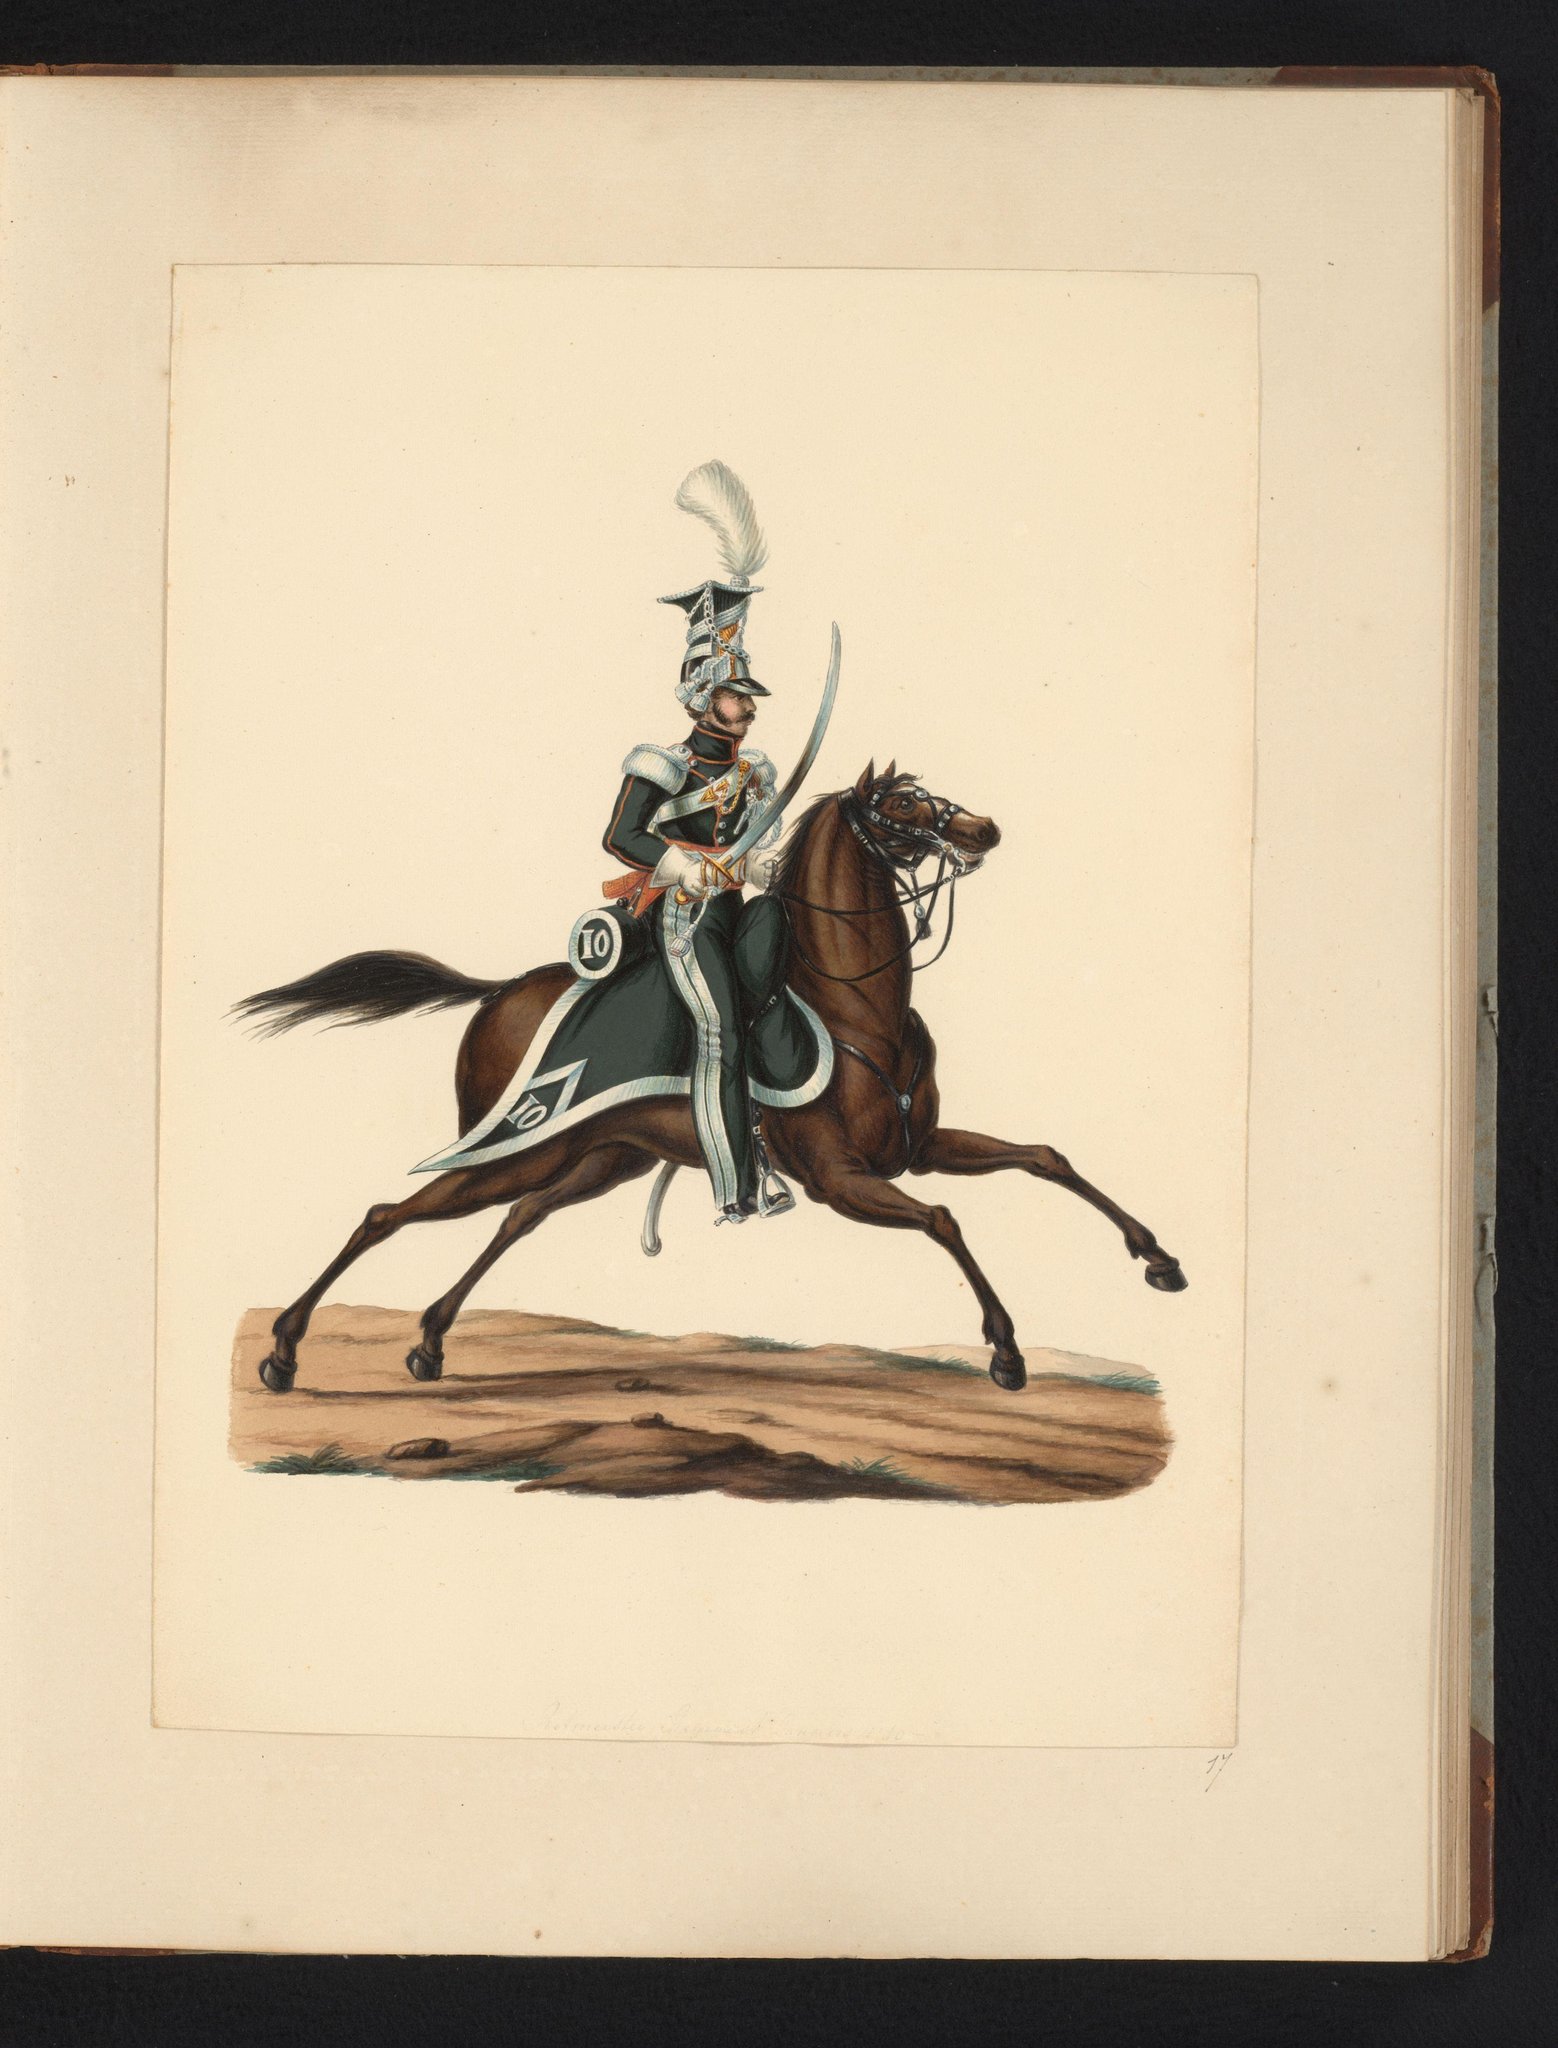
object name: costume print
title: Ritmester van de lansiers, 1830-1831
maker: Anonymous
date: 1831-1832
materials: paper, pencil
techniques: brush, lacquer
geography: netherlands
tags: professional clothes, (military) uniforms, netherlands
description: Een ritmeester van het 10e Regiment Lansiers, te paard. Onderdeel van het album met 39 ingeplakte tekeningen van militairen van de Koninklijke Nederlandsche Armee uit 1830-1831.